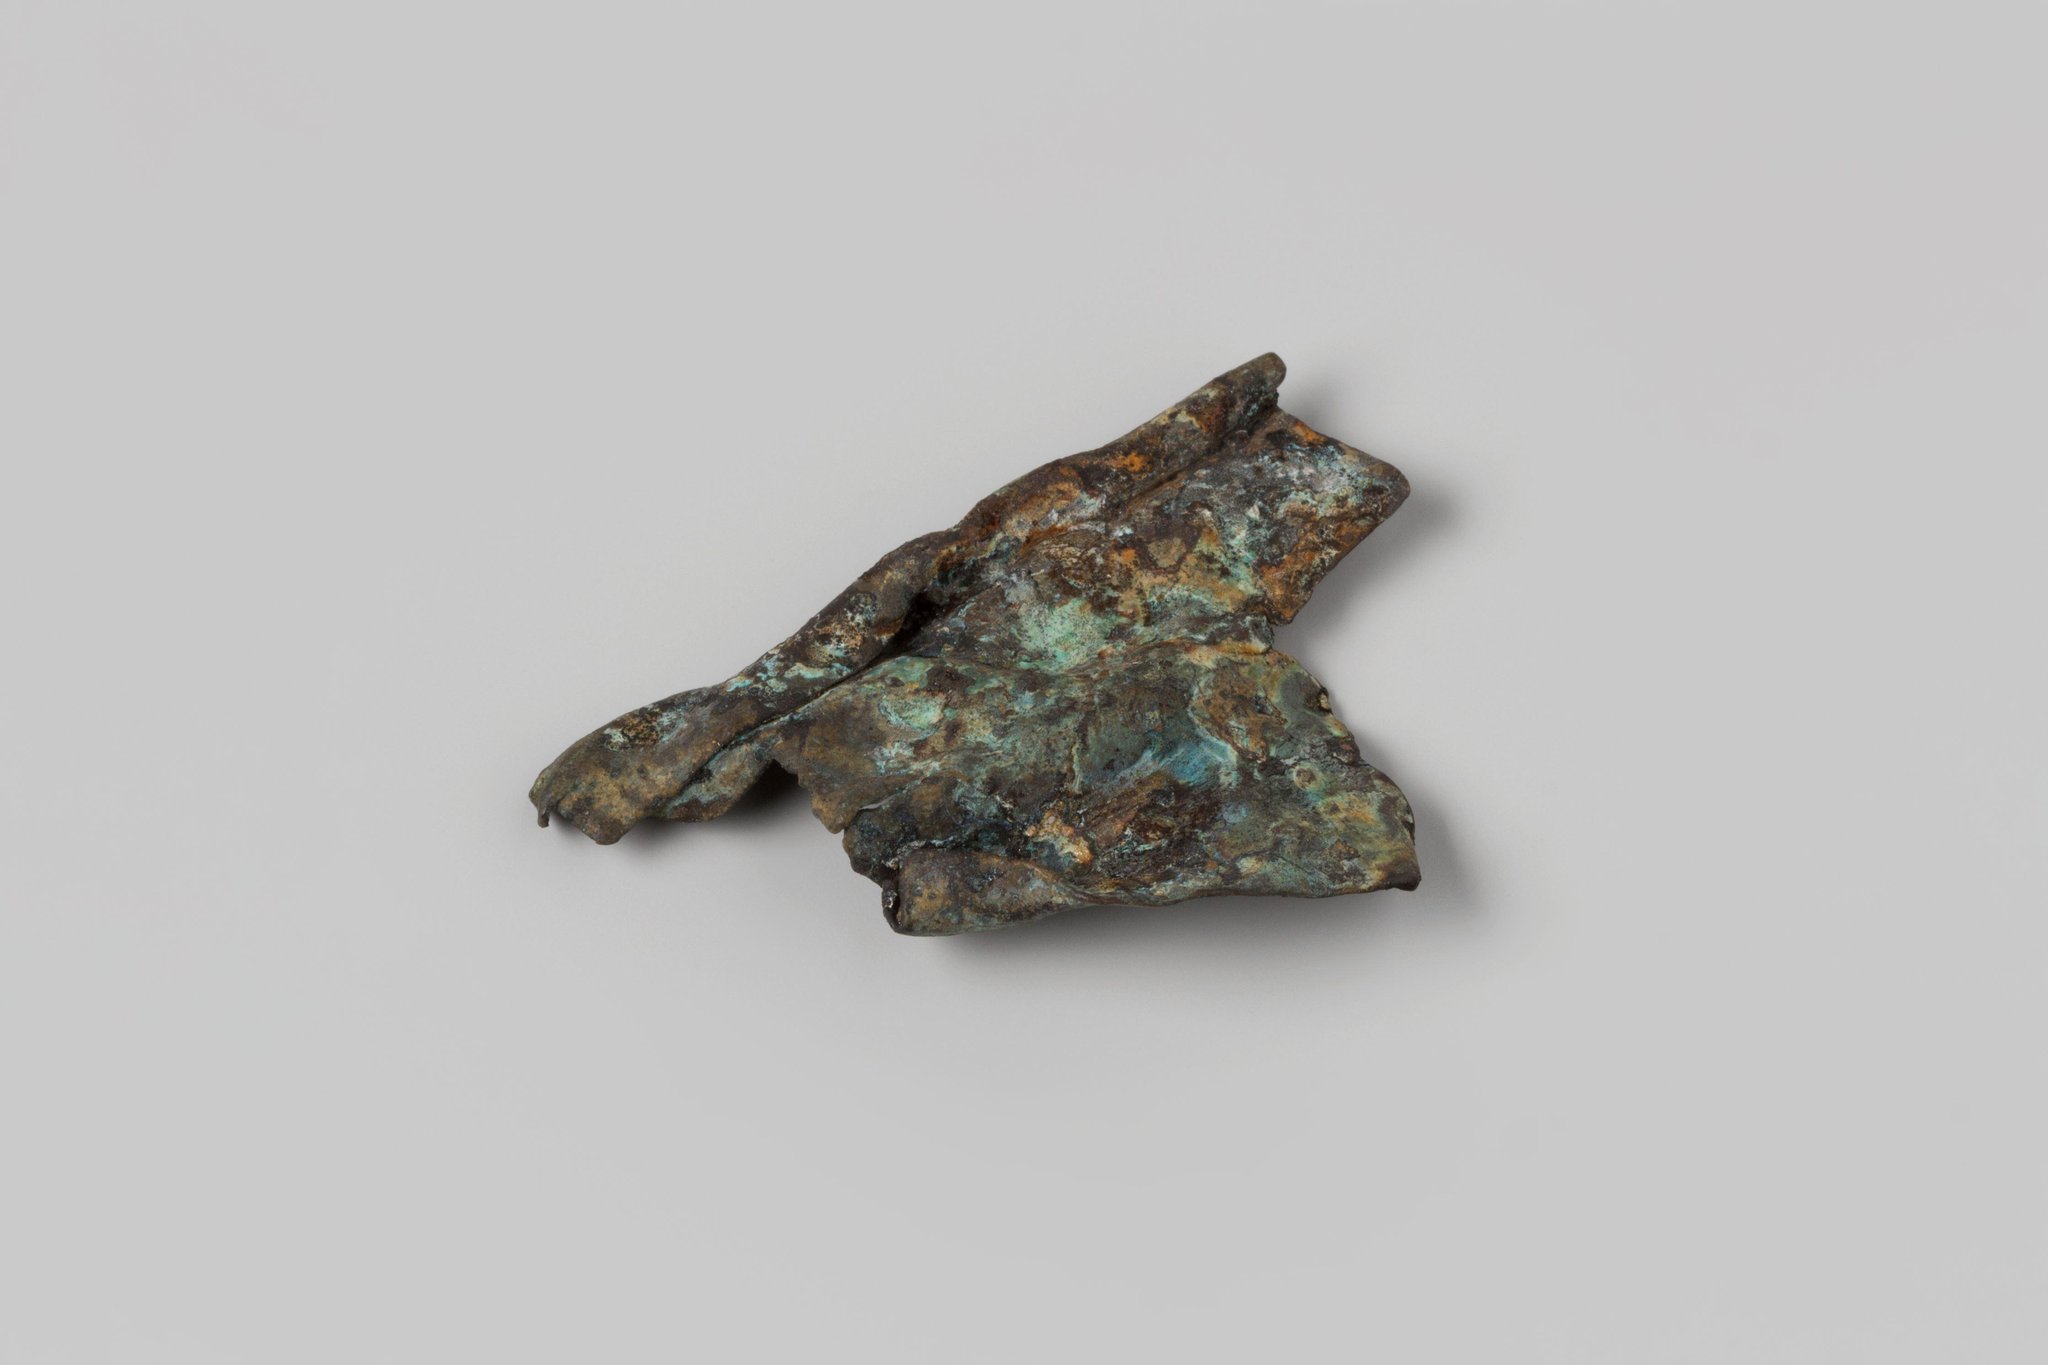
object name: scheepswrakvondst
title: Fragment van koper uit het wrak van de Oost-Indiëvaarder Hollandia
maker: Anonymous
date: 1700-1743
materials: copper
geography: netherlands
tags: verenigde oostindische compagnie, hollandia (schip), annet